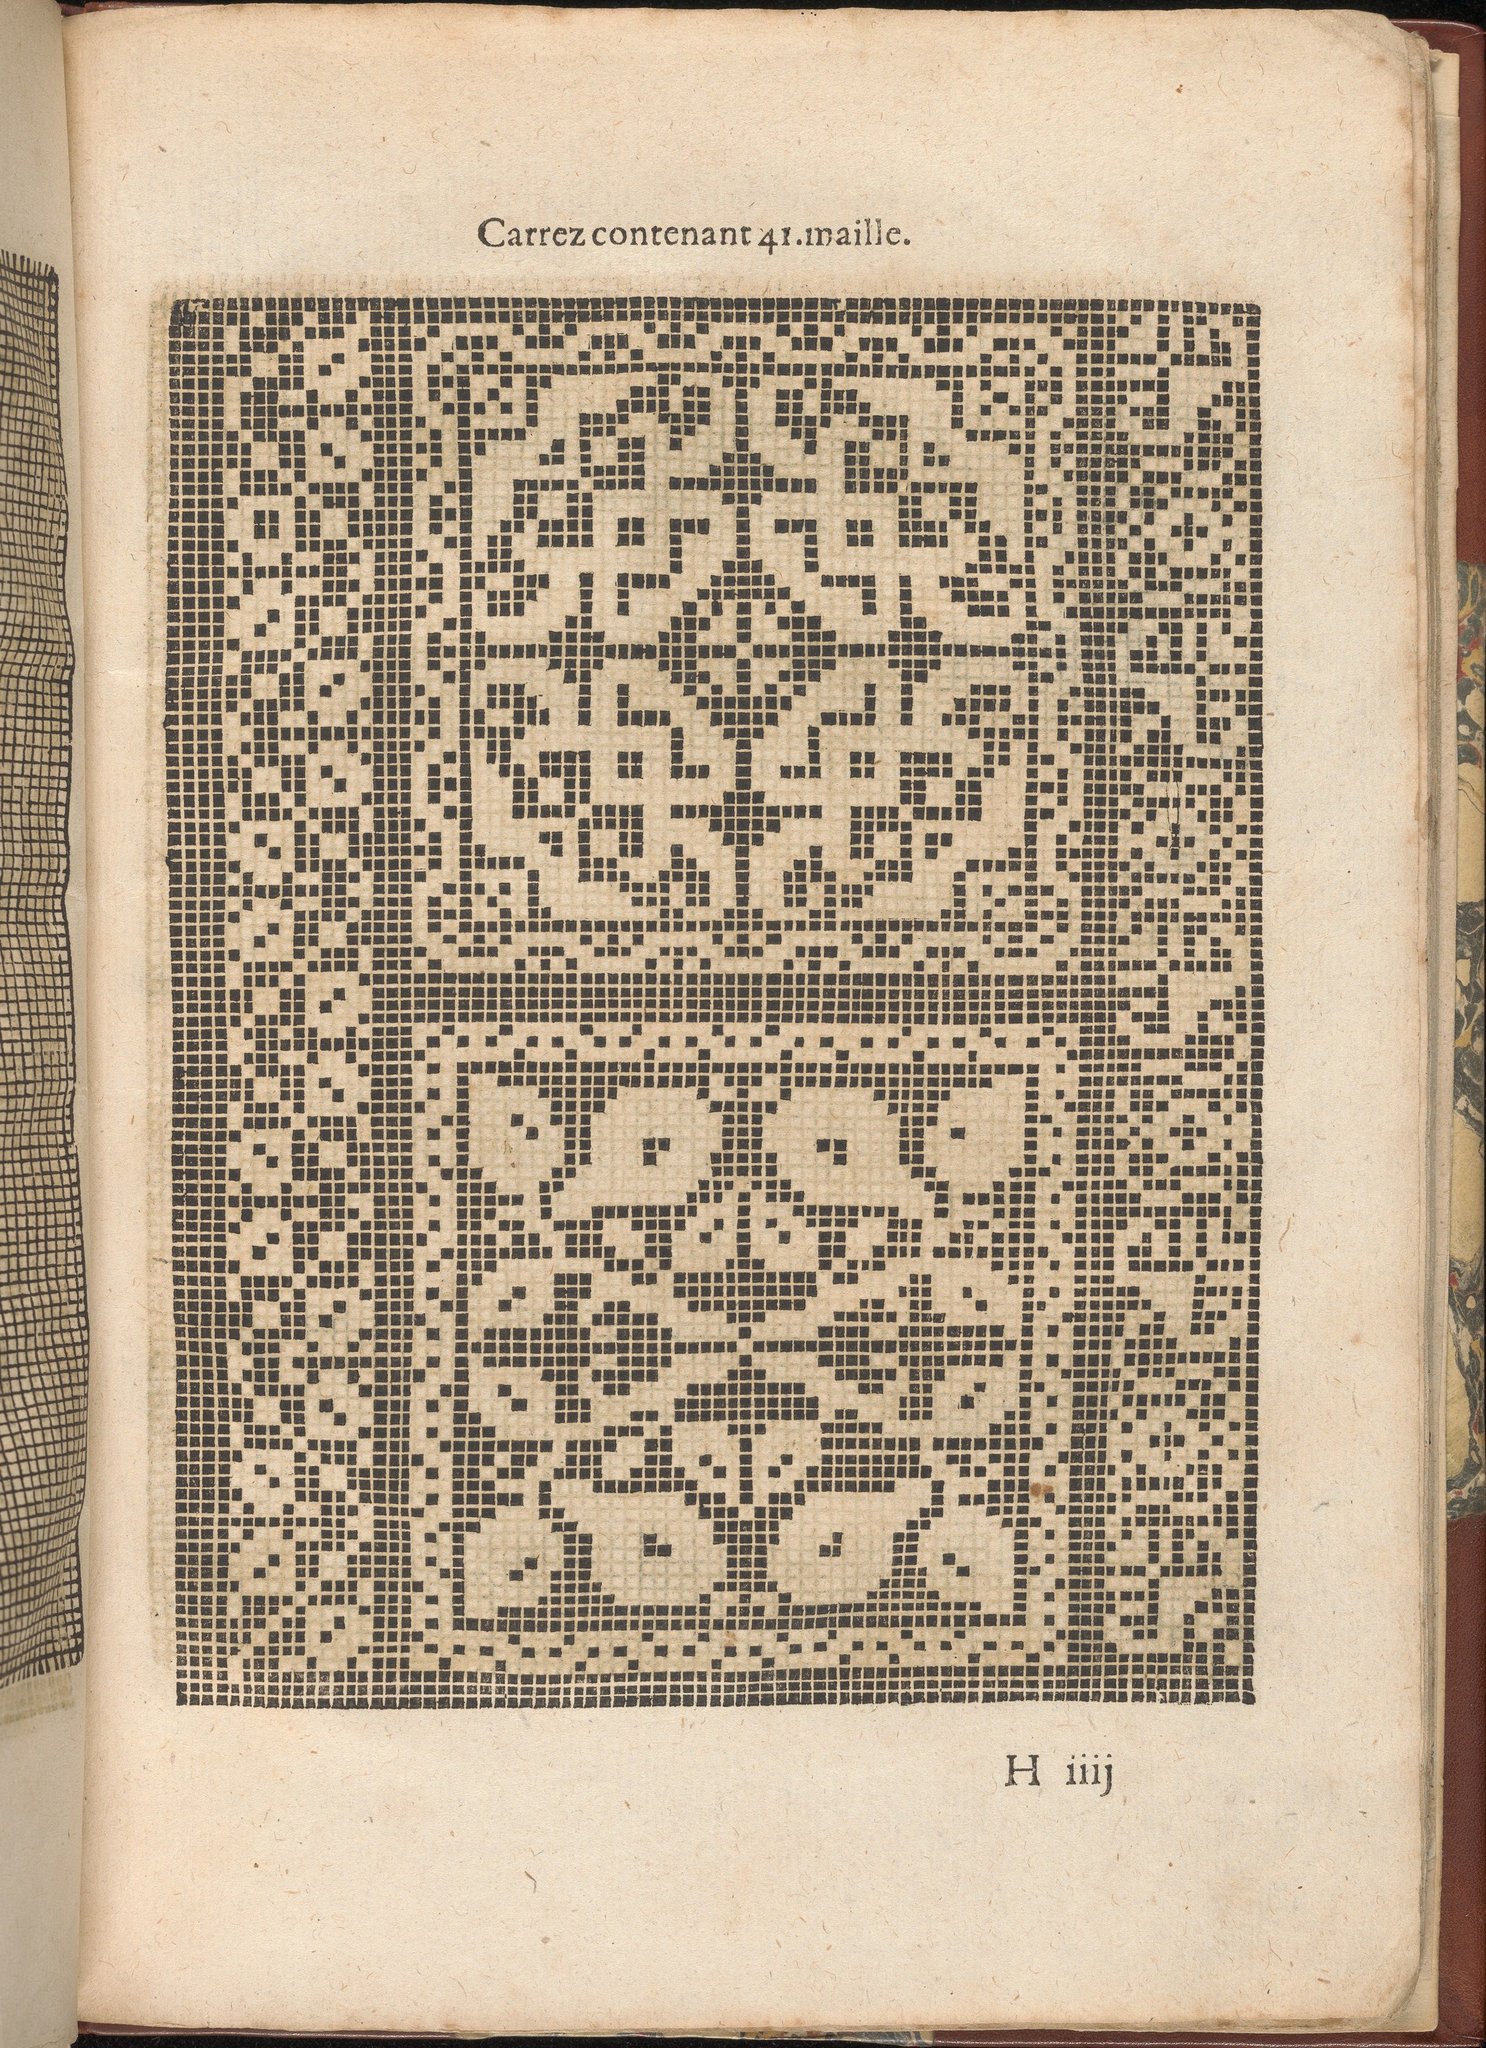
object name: book print ornament architecture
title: Les Secondes Oeuvres, et Subtiles Inventions De Lingerie du Seigneur Federic de Vinciolo Venitien, page 32 (recto)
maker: federico de vinciolo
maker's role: designer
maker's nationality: italian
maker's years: 1582-1599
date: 1603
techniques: woodcut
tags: flowers